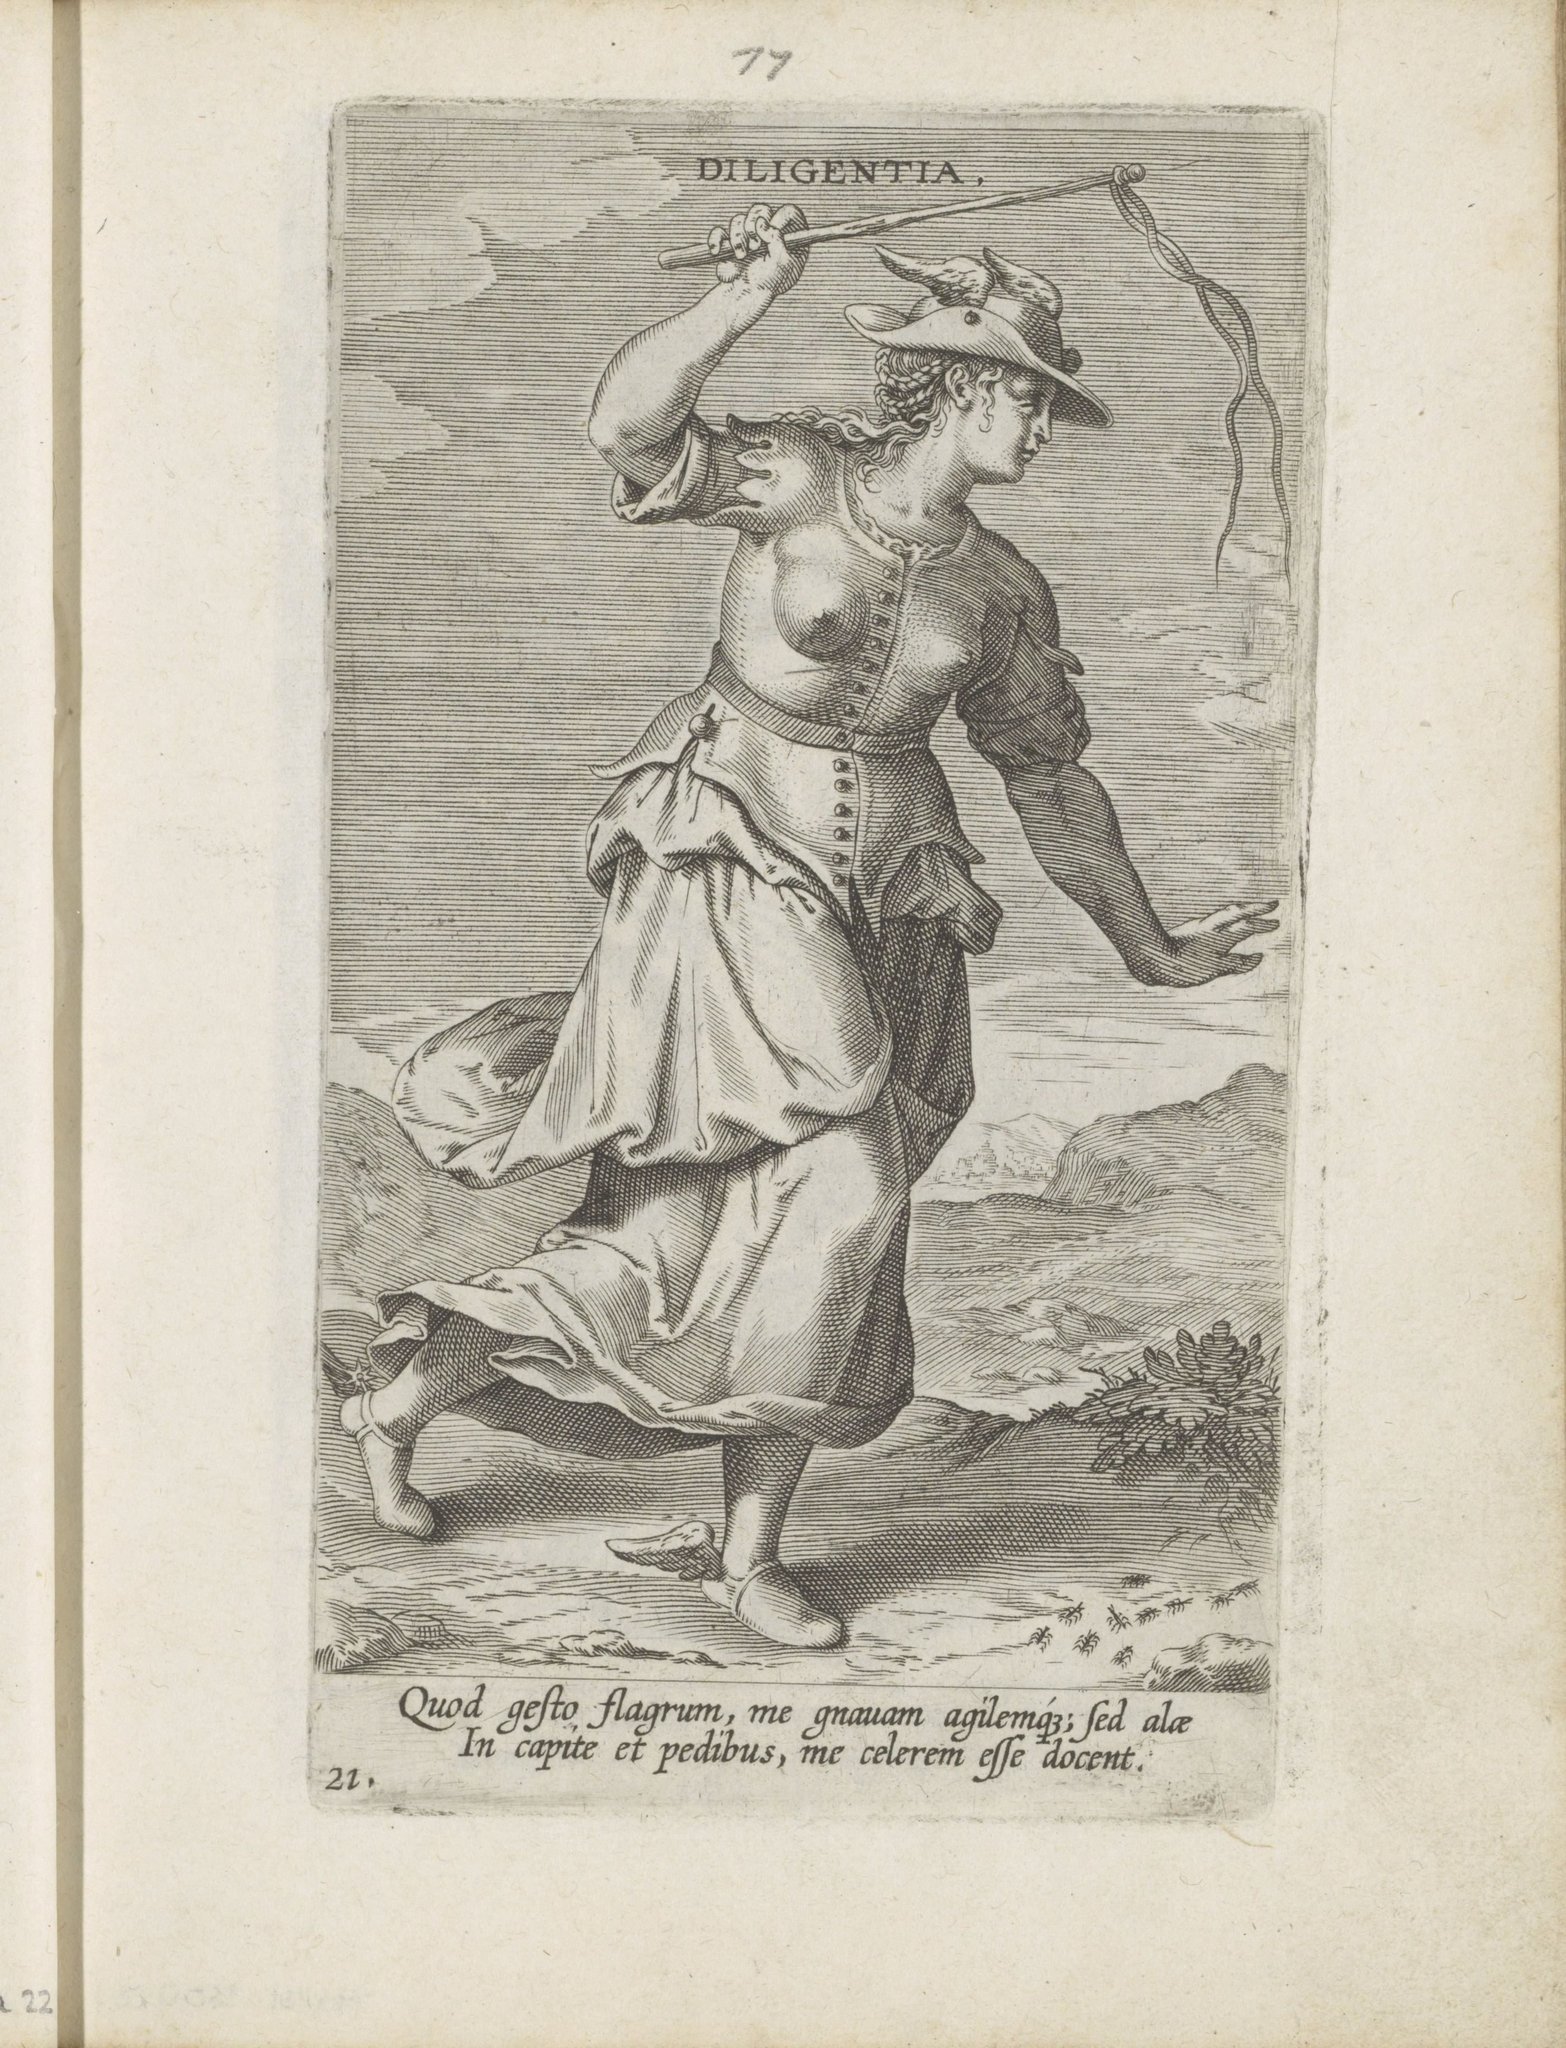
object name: album leaf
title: Prosopographia, sive virtutum, animi, corporis, bonorum externorum, vitiorum, et affectuum variorum delineatio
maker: philips galle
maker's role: print maker, publisher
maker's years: 1537-1612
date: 1585-1590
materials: paper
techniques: engraving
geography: southern netherlands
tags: carefulness, diligence; 'diligenza' (ripa)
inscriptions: collector's mark: Lugt 2760, collector's mark: Lugt 2228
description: Een vrouw met op haar hoed en aan haar schoenen twee vleugels en in haar rechterhand een zweep. Op de voorgrond bewegen zich een aantal mieren voort. Mieren zijn het symbool van vlijt en arbeid. Onder de voorstelling twee regels tekst in het Latijn. De prent maakt deel uit van een album.